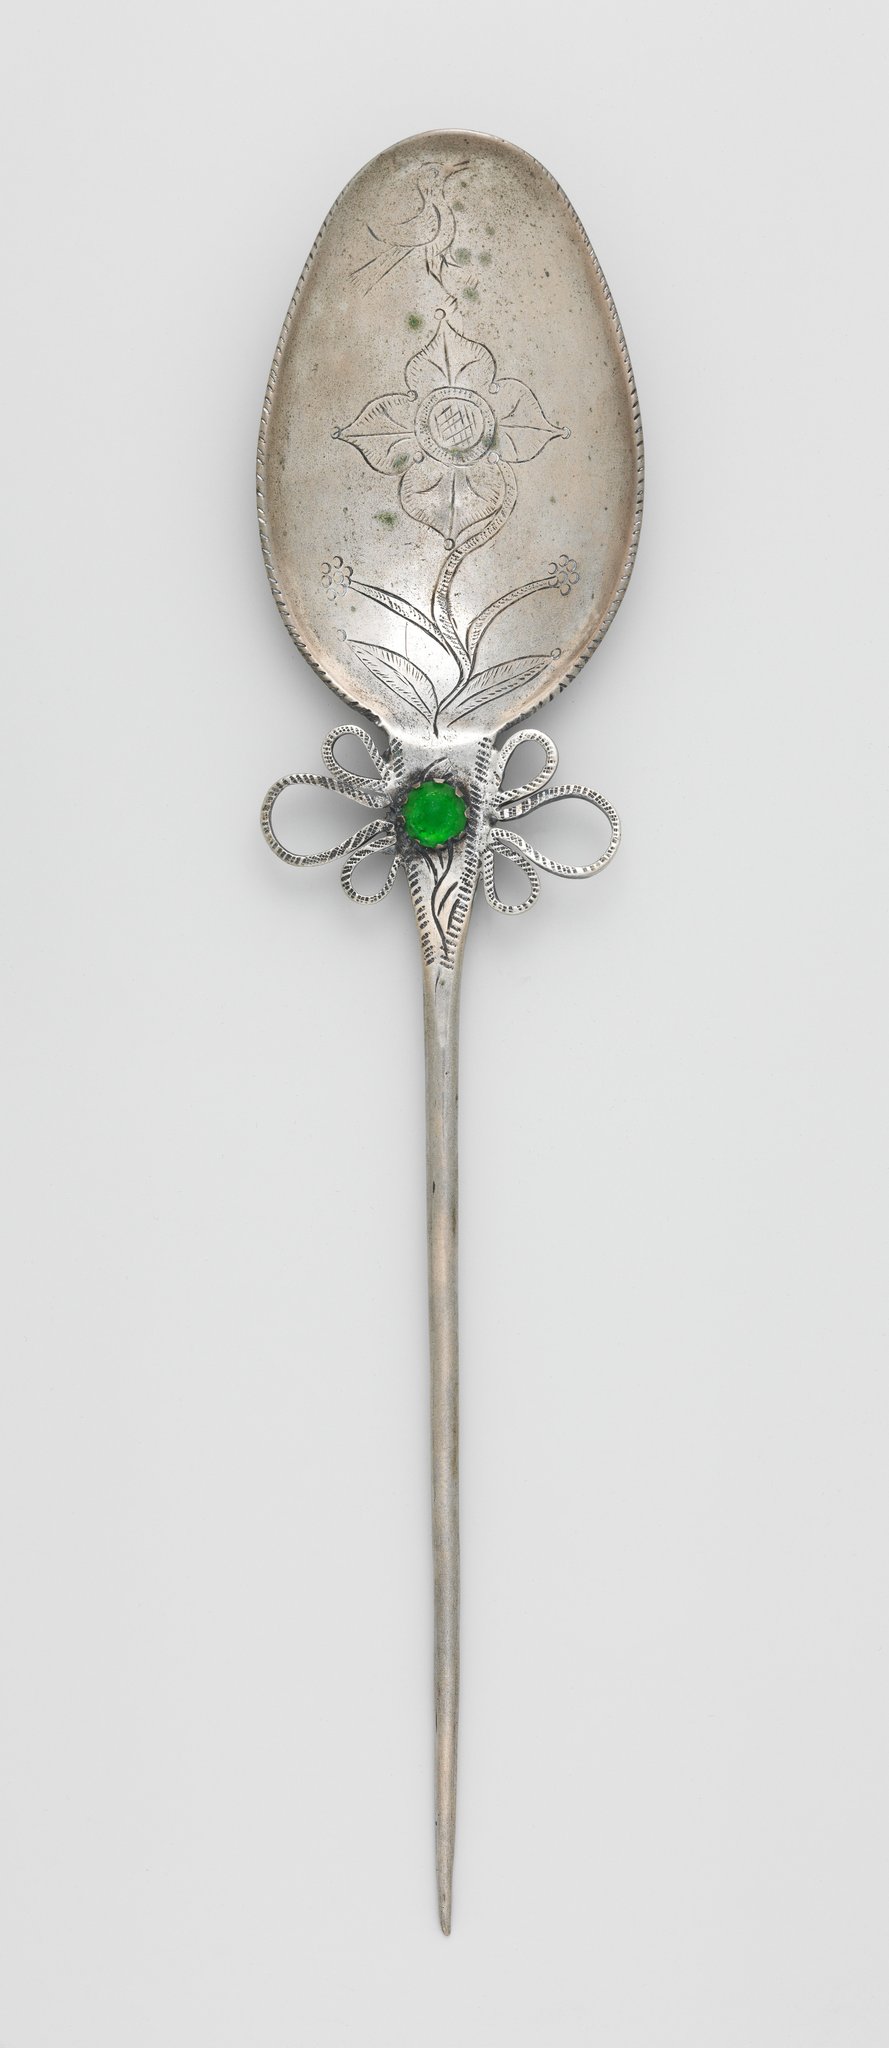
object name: pin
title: Pin (ttipqui)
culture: peruvian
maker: peruvian artist(s)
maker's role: artist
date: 1801-1900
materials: glass, silver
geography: peru